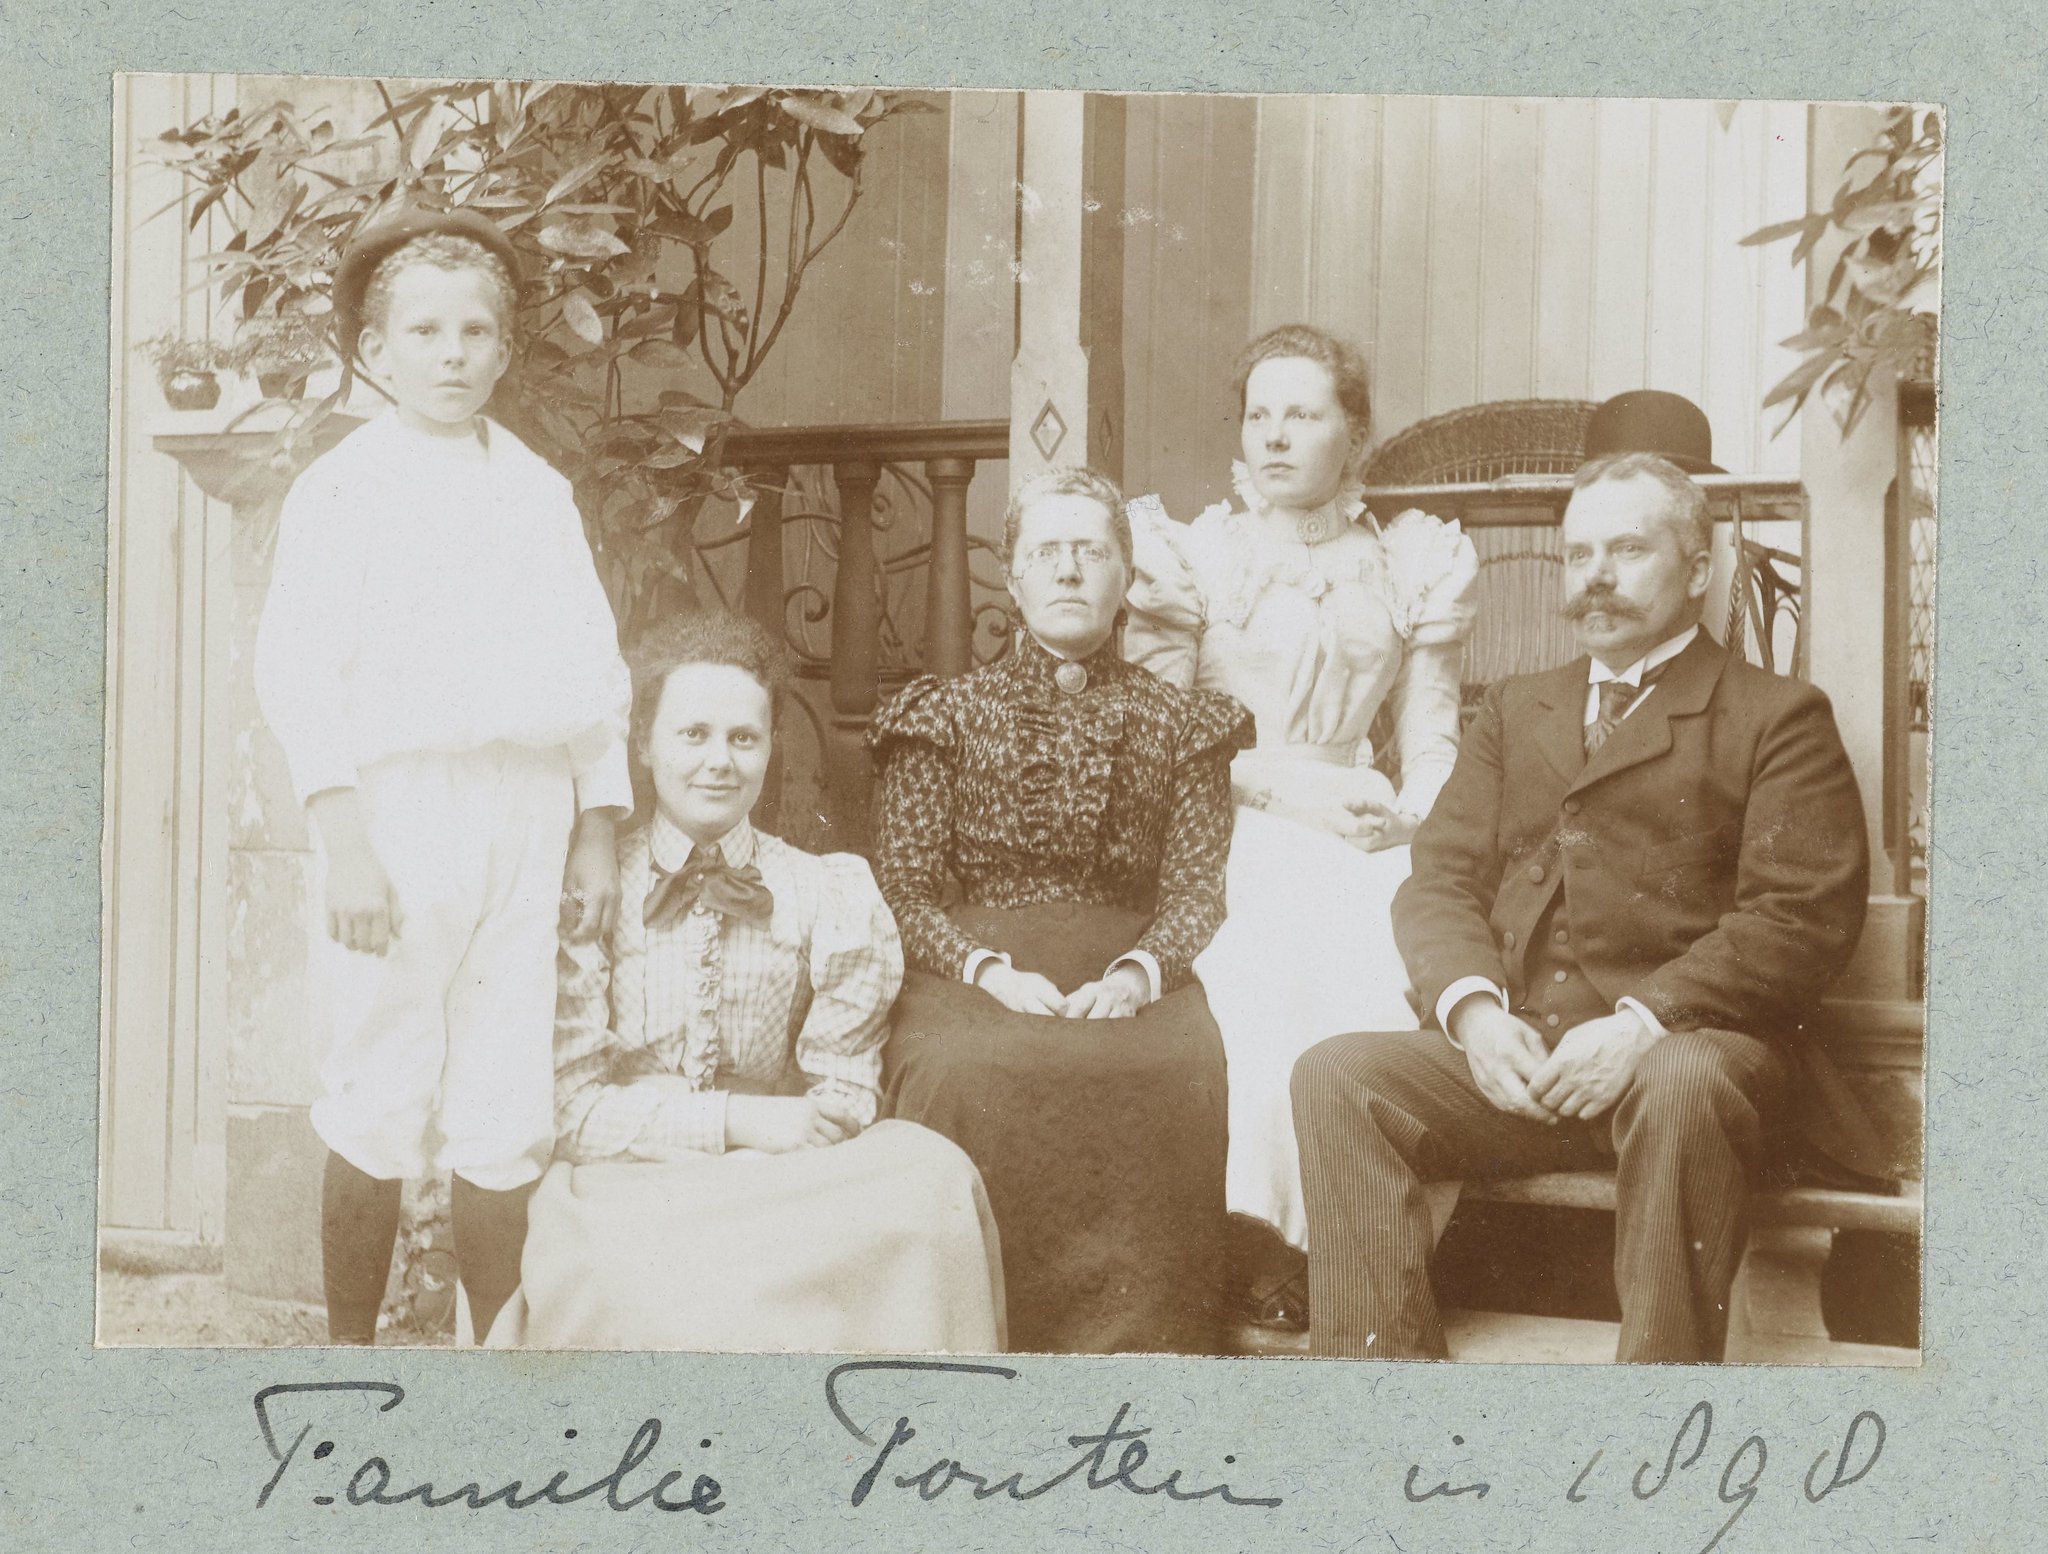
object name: photograph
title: Familieportret Fontein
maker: frits freerks fontein fz.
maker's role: fotograaf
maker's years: 1882-1928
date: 1898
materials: cardboard, paper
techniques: gelatin silver print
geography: netherlands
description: De fotograaf maakte een foto van zijn broertje, twee zusters en zijn ouders. Op de foto zijn te zien: (uiterst links) broer Scato Freerks Fontein (1888-1946), zuster Anna Maria Freerks Fontein (1879-1952), zuster Martha Cornelia Freerks Fontein (1880-1955) en (midden) moeder jkvr Jansje Scatos Trip (1854-1940) gehuwd met (uiterst rechts) vader Freerk Freerks Fontein (1847-1918). Het gezin woonde in Harlingen op Voorstraat 80.